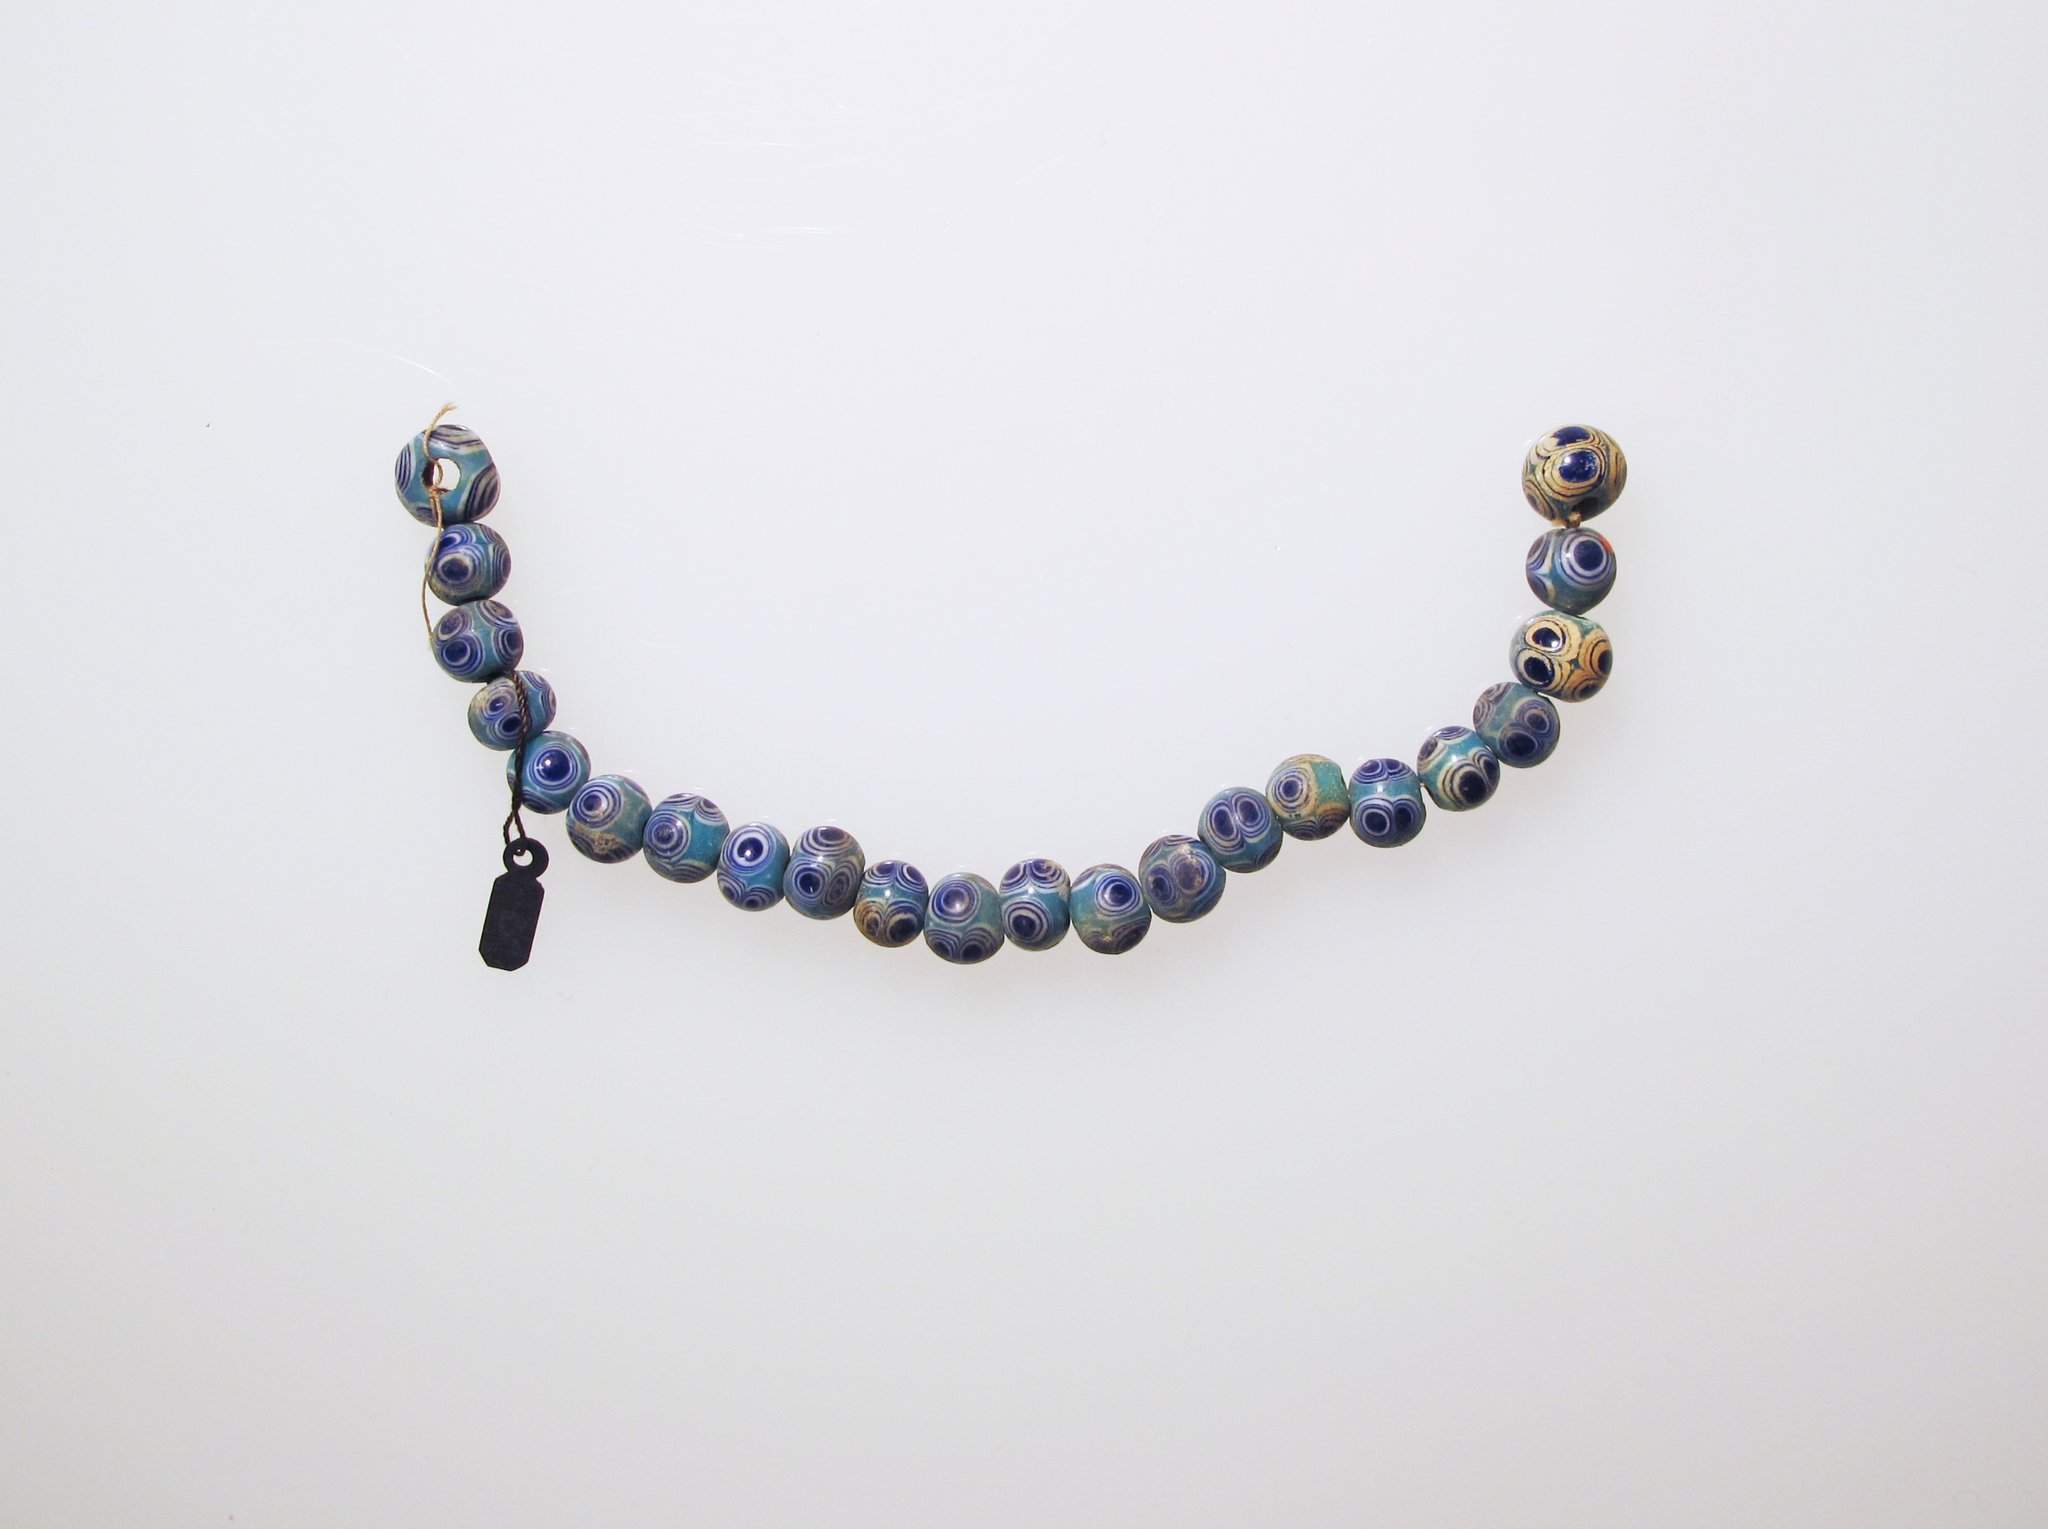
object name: bead, 22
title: Beads, 22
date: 7000 BCE-330 CE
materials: glass